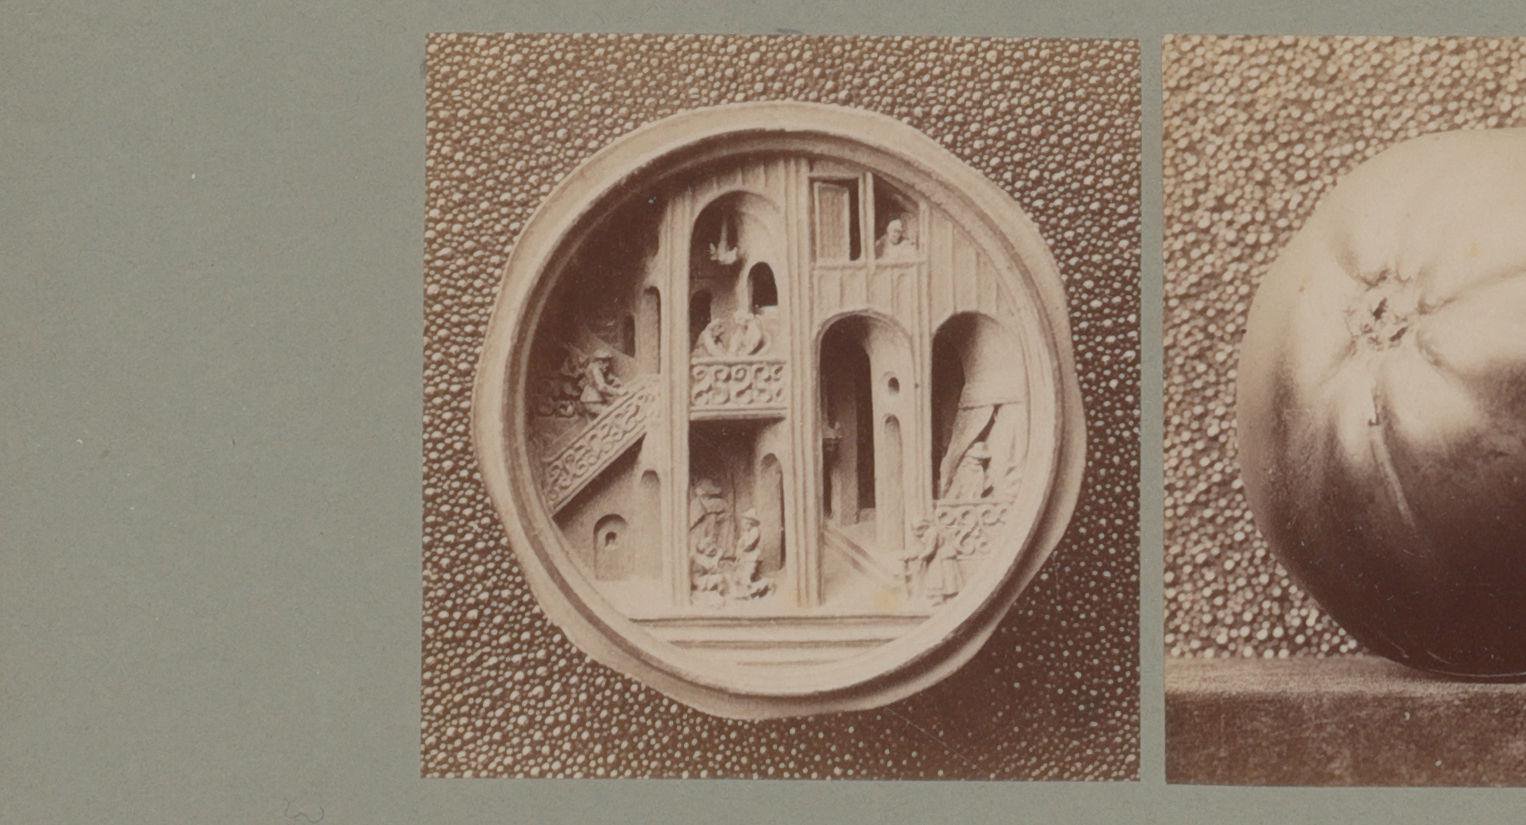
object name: photograph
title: Gebedsnoot, binnenkant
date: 1872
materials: photographic support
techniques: albumen print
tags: carving ~ applied arts, piece of sculpture, reproduction of a piece of sculpture, interior of the house, wood carver, the (seven) acts of mercy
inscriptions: collector's mark, collector's mark: Lugt 1641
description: Binnenkant van een geopende gebedsnoot met een uitbeelding van de zeven werken van barmhartigheid in een huiselijk interieur. De noot bevond zich in de collectie van dhr. C. Becker te Frankfurt am Main. Onderwerpsrubrieken binnen de Atlas Zeden en Gewoonten: Beeldhouw- en snijkunst.